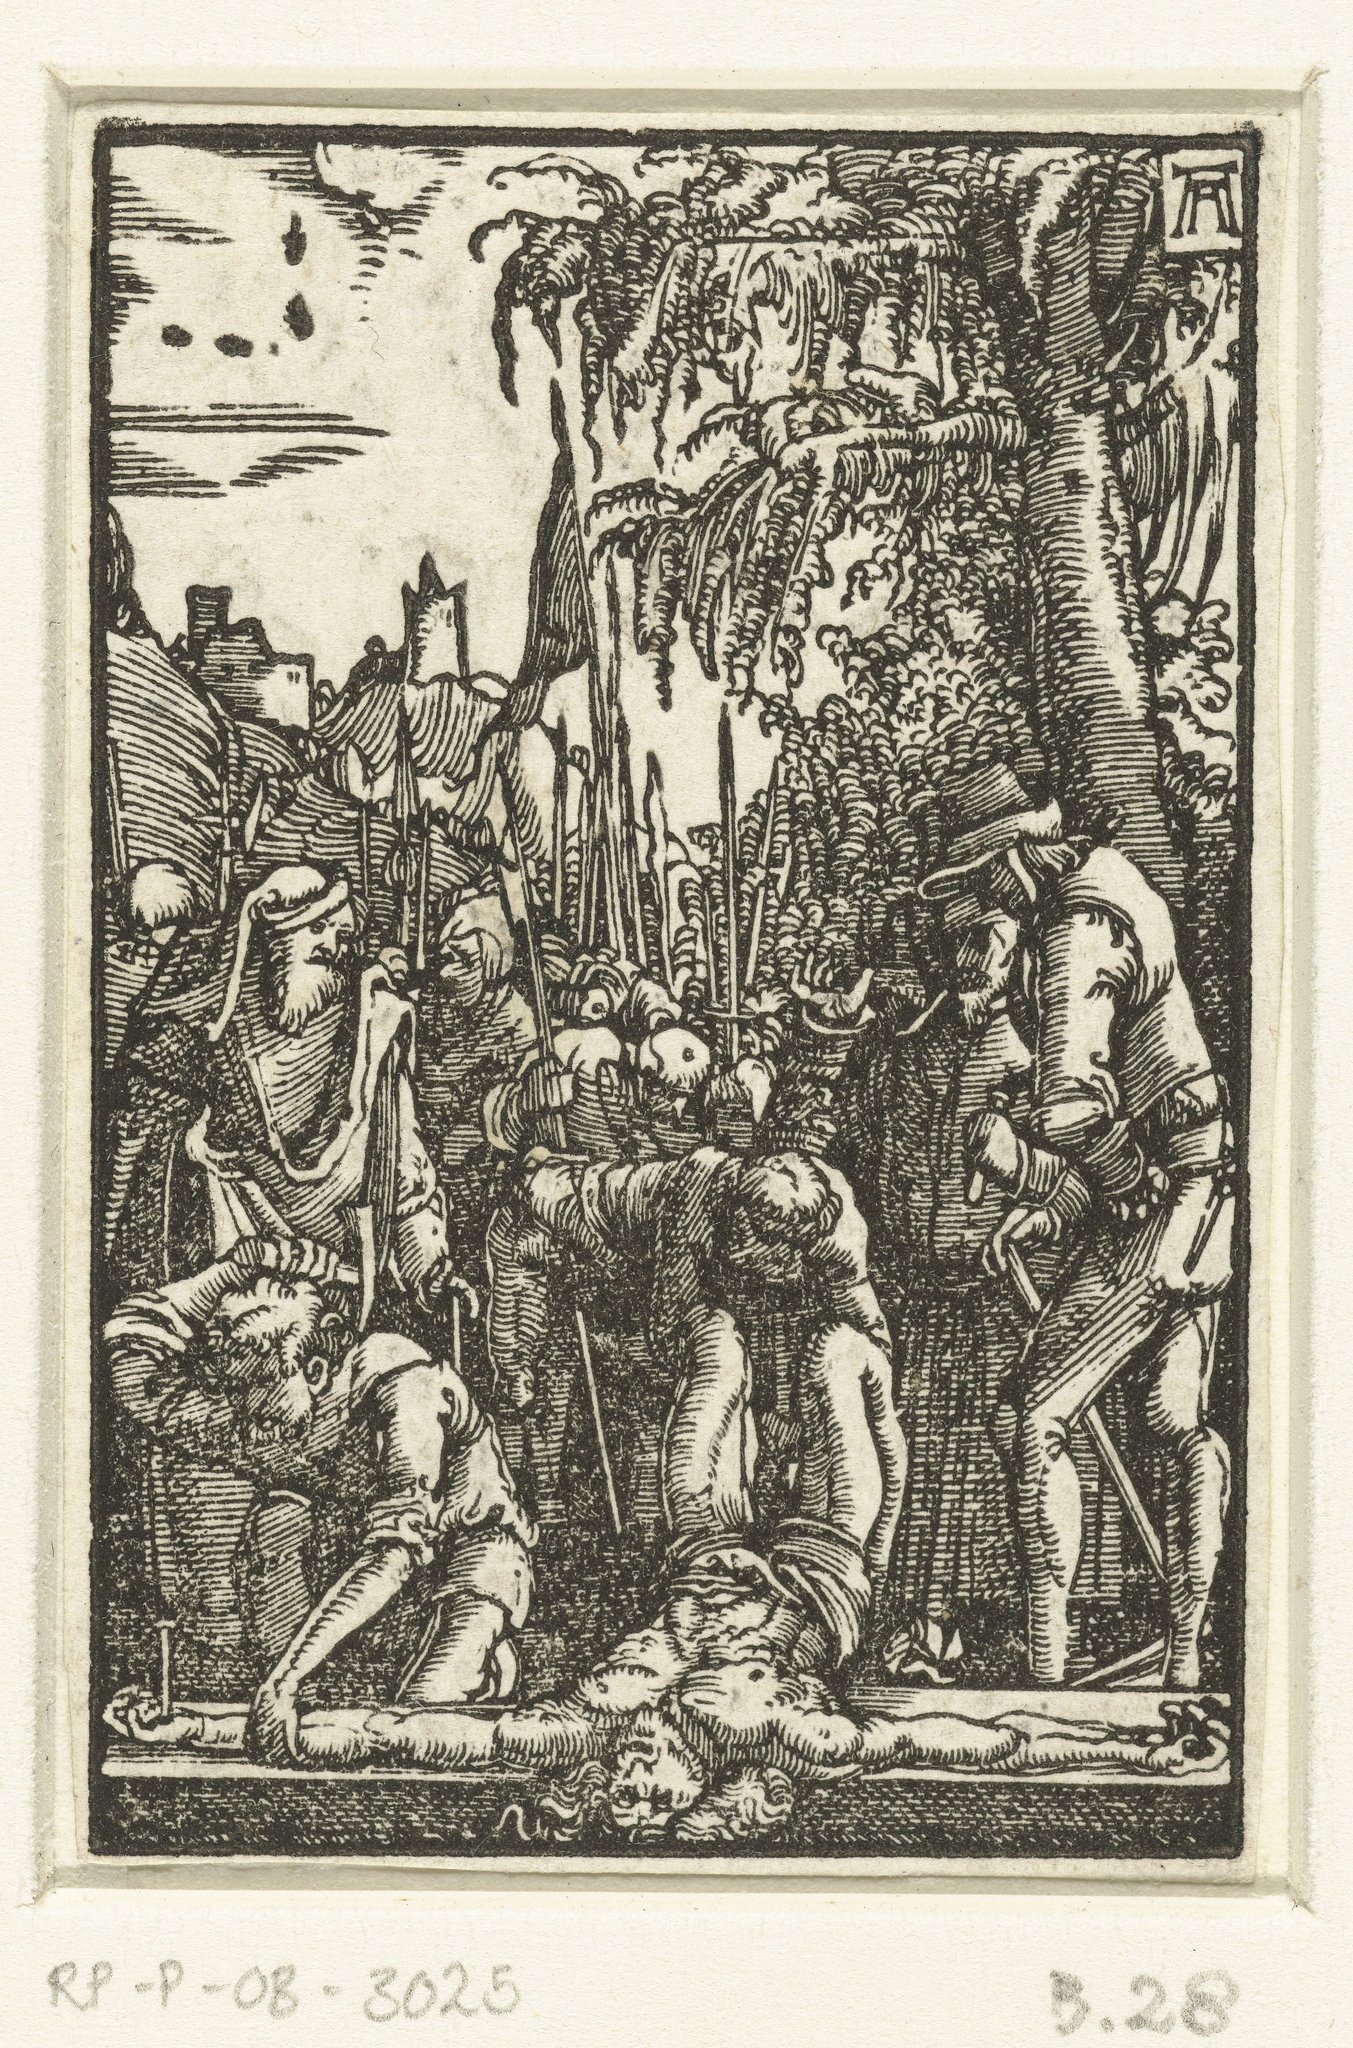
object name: print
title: Christus aan het kruis genageld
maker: albrecht altdorfer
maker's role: draughtsman, print maker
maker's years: 1480-1538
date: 1506-1538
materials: paper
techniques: woodcut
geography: germany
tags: the erection of the cross: christ is nailed to the cross which lies on the ground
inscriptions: number: ‘58’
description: Christus wordt vastgenageld aan het kruis, liggend op de grond. Links slaat een man een nagel door de hand van Christus. Achtentwintigste prent uit een serie van veertig.